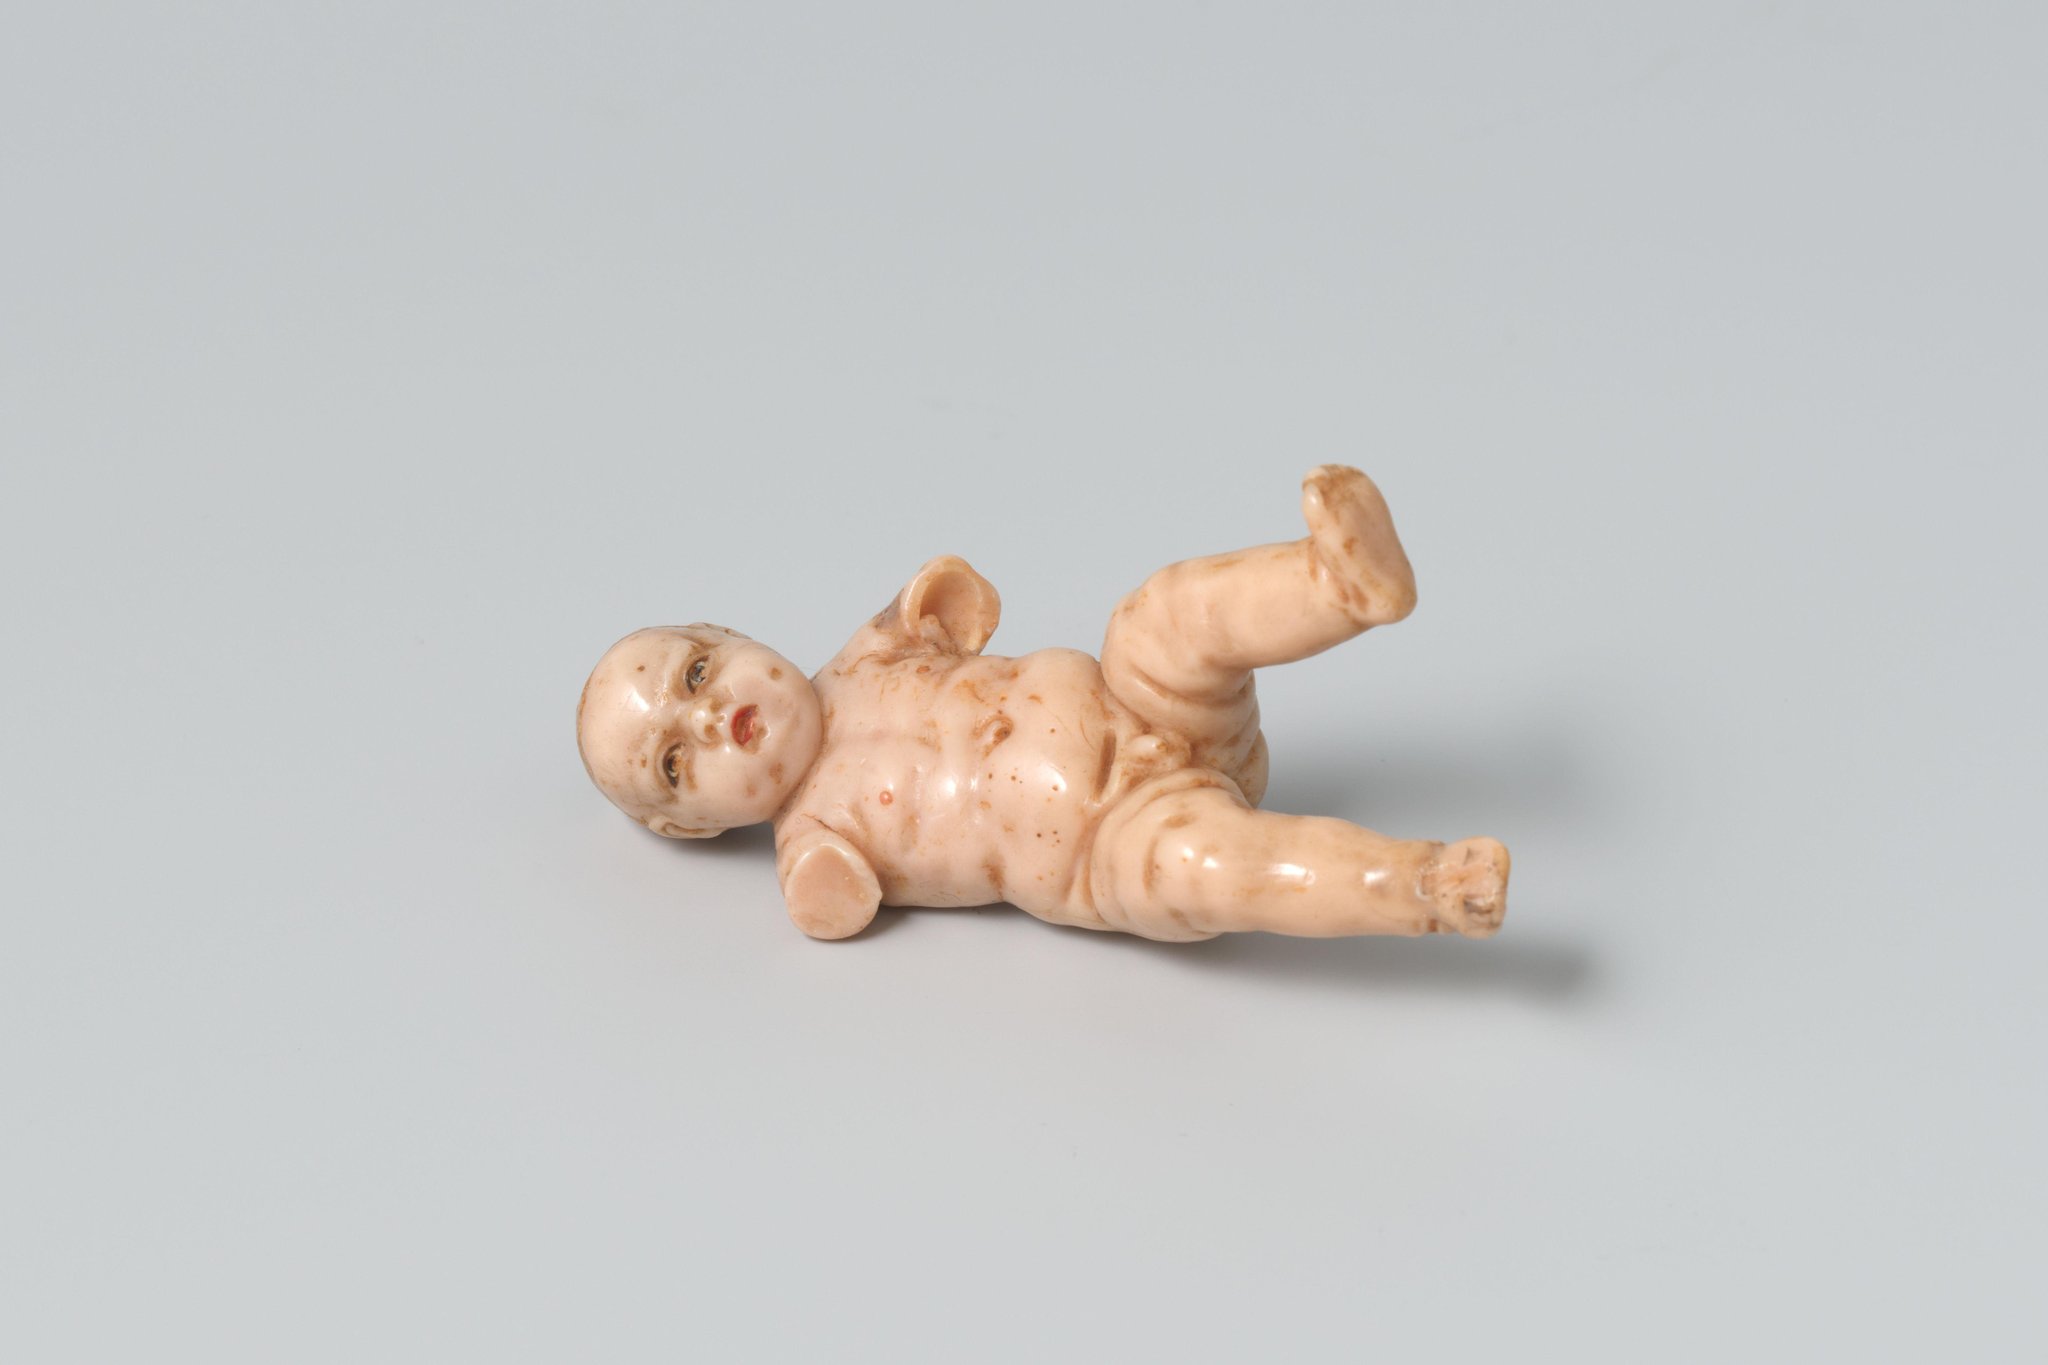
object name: toy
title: Pop, voorstellende een naakte jongensbaby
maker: Anonymous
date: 1676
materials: silk, wax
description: Pop, voorstellende een naakte jongensbaby.